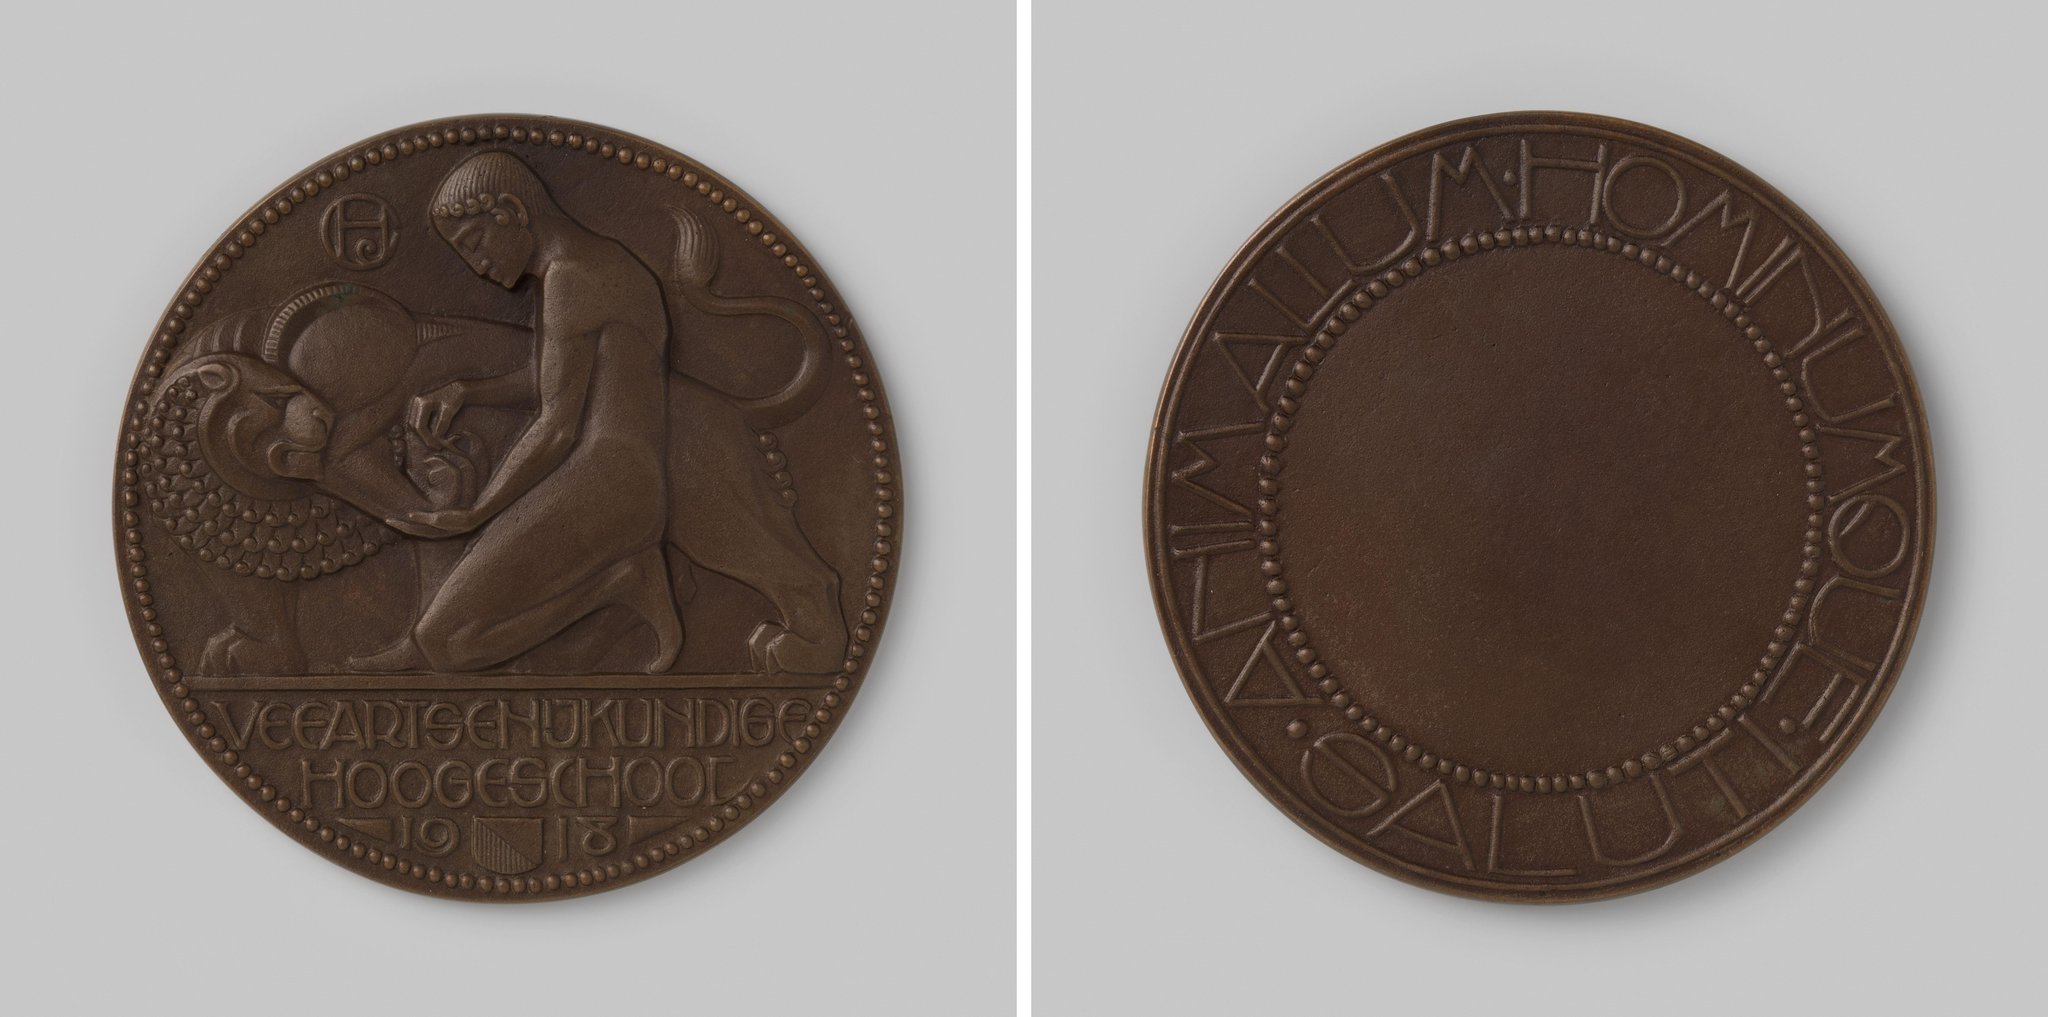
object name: history medal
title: Beloningspenning van de Veeartsenijkundige Hoogeschool te Utrecht 1918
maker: chris van der hoef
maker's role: ceramicist, draughtsman, sculptor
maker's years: 1875-1933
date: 1918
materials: bronze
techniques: casting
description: Grote bronzen penning, op de voorzijde Androklus die een splinter uit de poot van een leeuw verijdert, met afsnedetekst, op de keerzijde een inscriptieveld met omschrift.